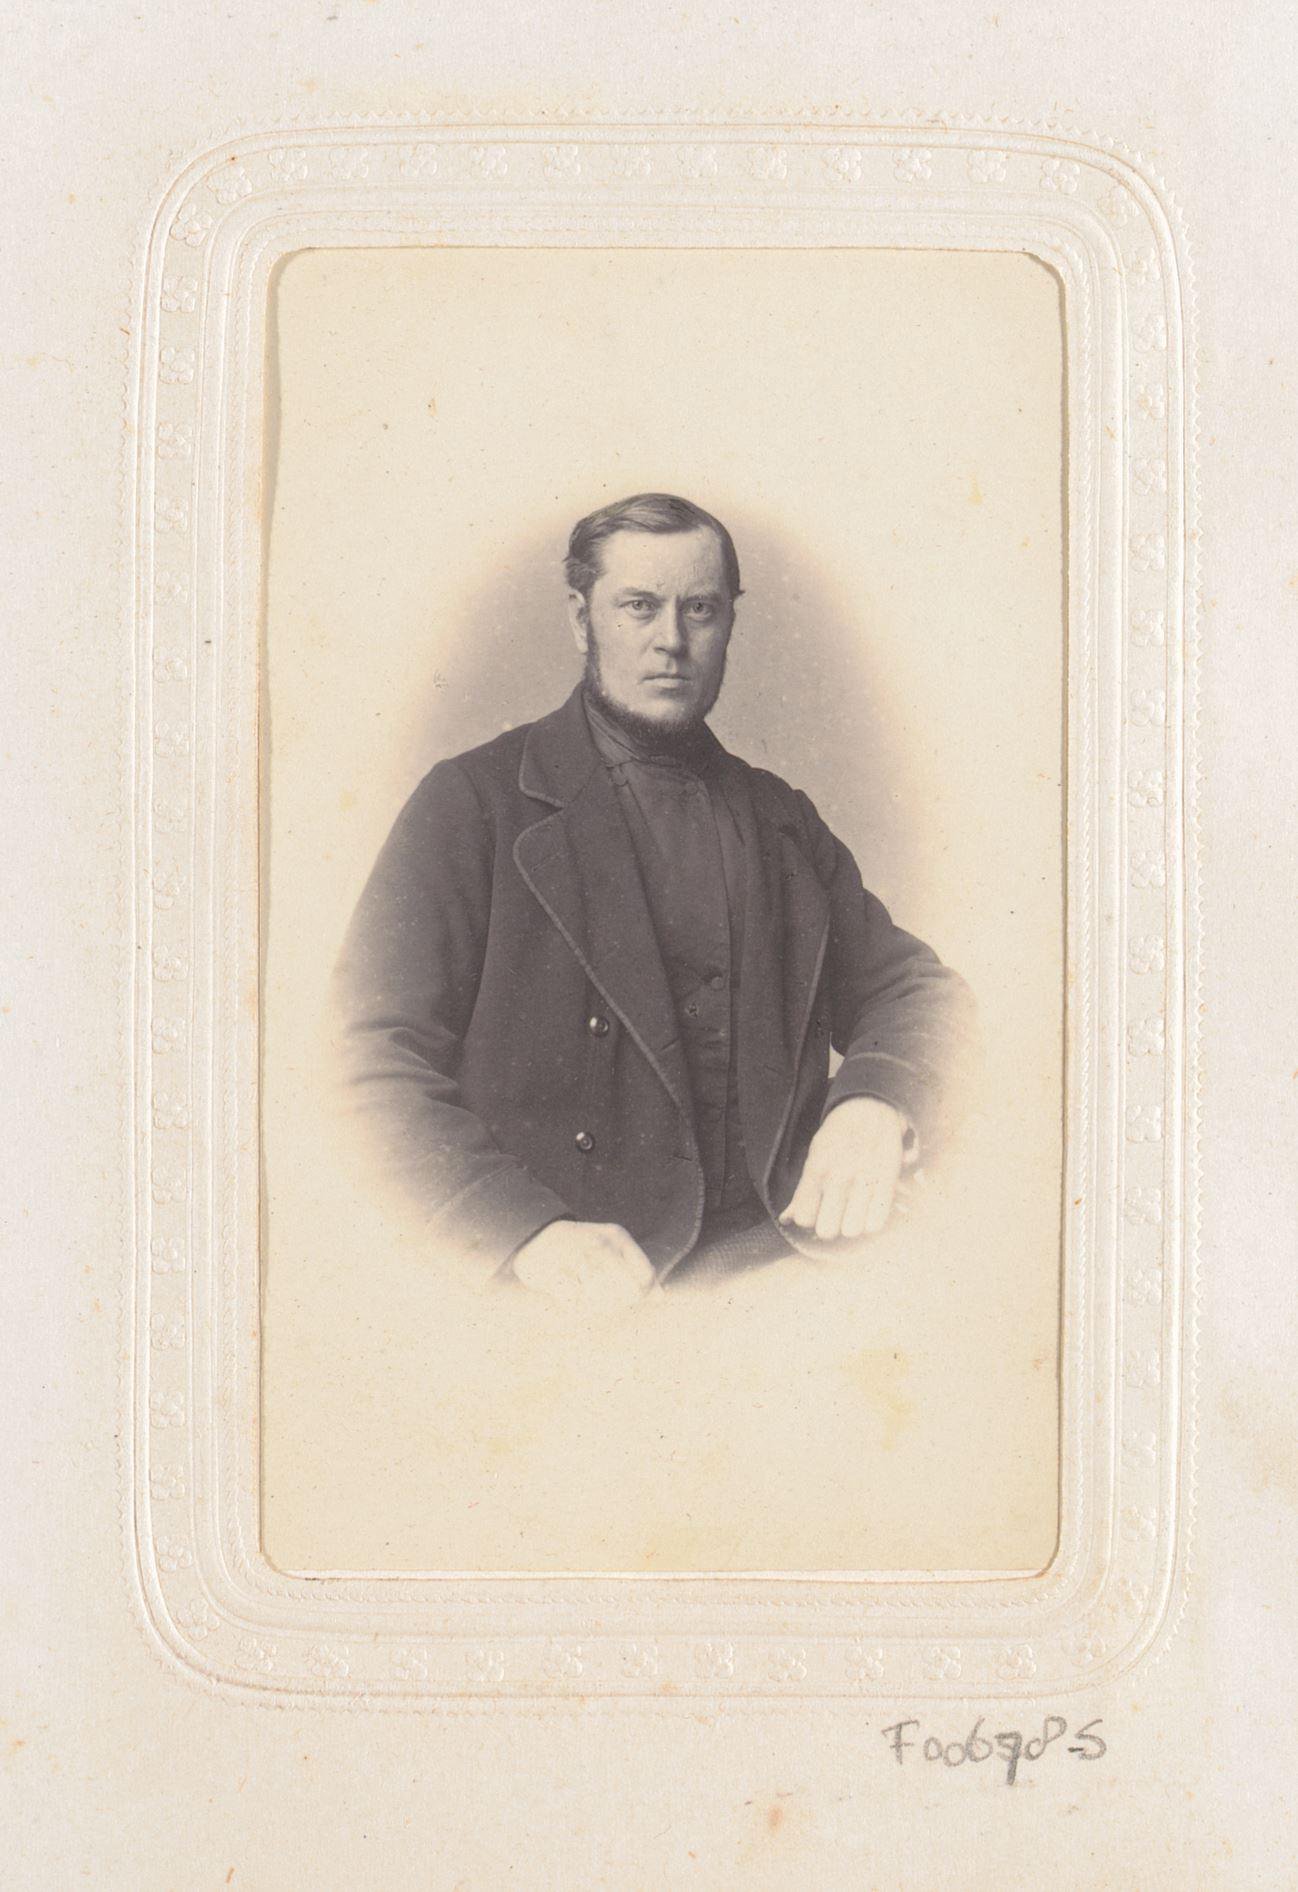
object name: album leaf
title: Portret van een man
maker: friedrich brandt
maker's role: fotograaf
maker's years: 1823-1891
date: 1860-1880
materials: cardboard, photographic support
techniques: albumen print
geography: flensburg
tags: historical persons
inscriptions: inscription: ‘F. Brandt's photographisches atelier in Flensburg’